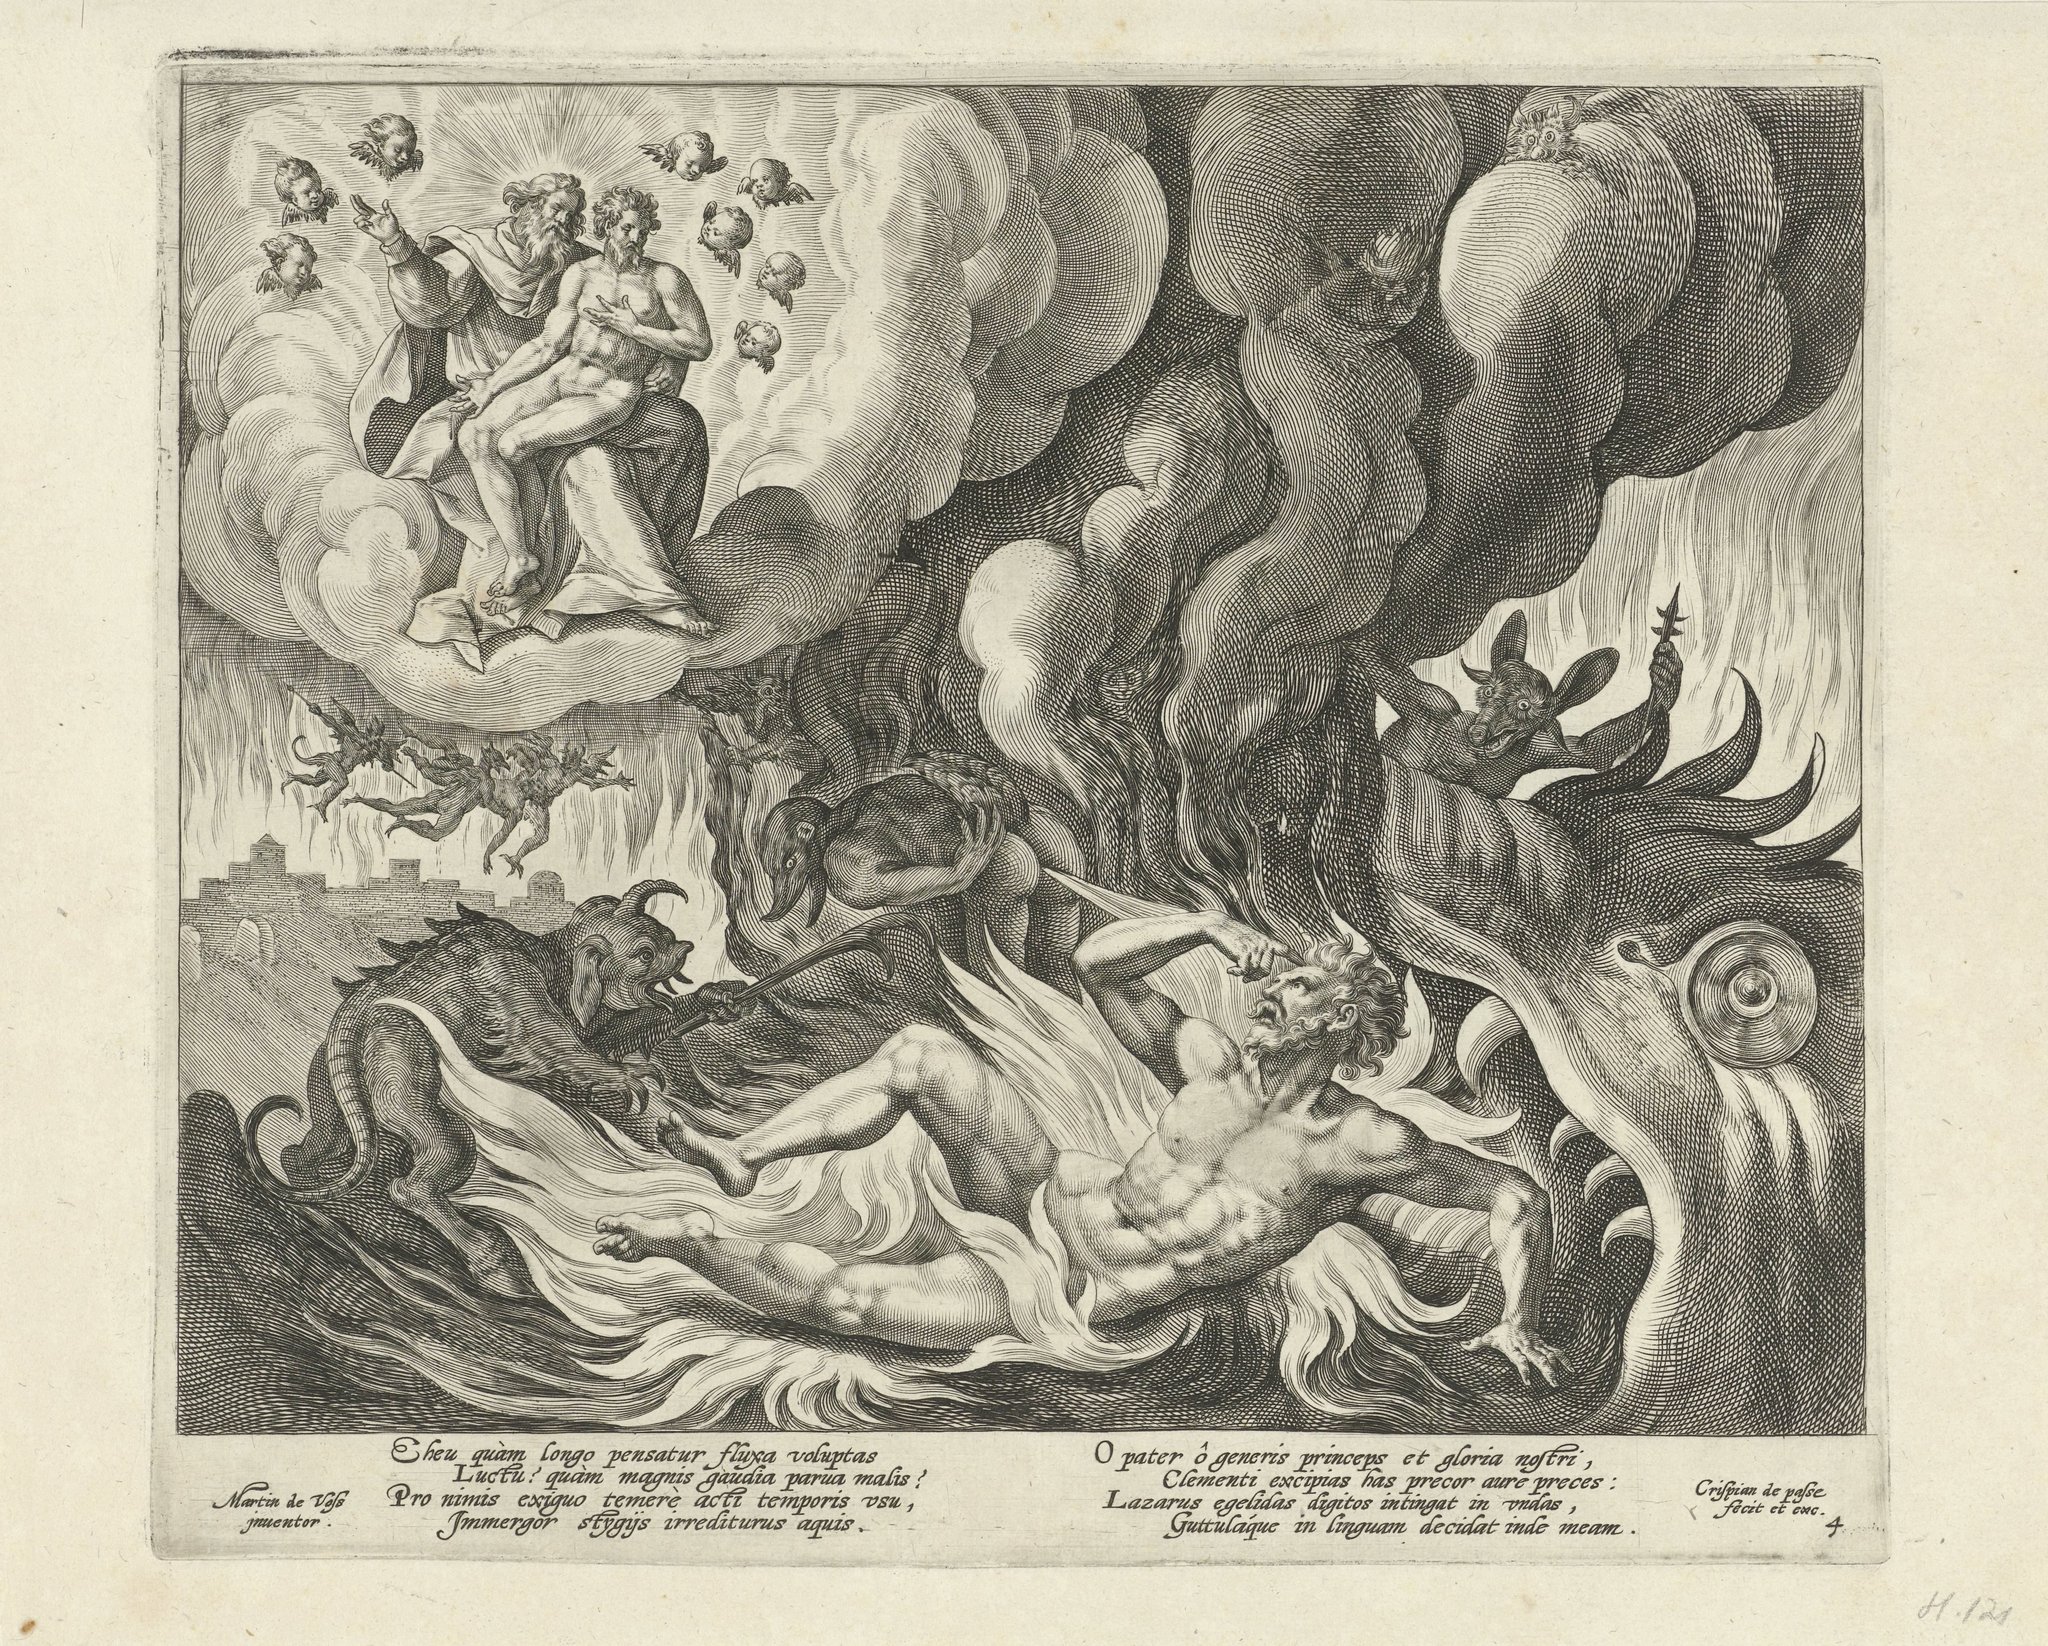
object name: print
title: Gelijkenis van de rijke man en de arme Lazarus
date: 1589-1611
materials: paper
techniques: engraving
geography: cologne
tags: in hell dives sees lazarus in paradise; usually dives pointing at his tongue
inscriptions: collector's mark: Lugt 2760, collector's mark: Lugt 2228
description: De rijke man brandt in de hel en wordt door duivels bedreigd. Hij ziet Lazarus in de hemel op de schoot van Abraham. Op de achtergrond wordt de ziel van de rijke man meegenomen naar de hel. Prent uit een serie van vier met de gelijkenis van de rijke man en de arme Lazarus.